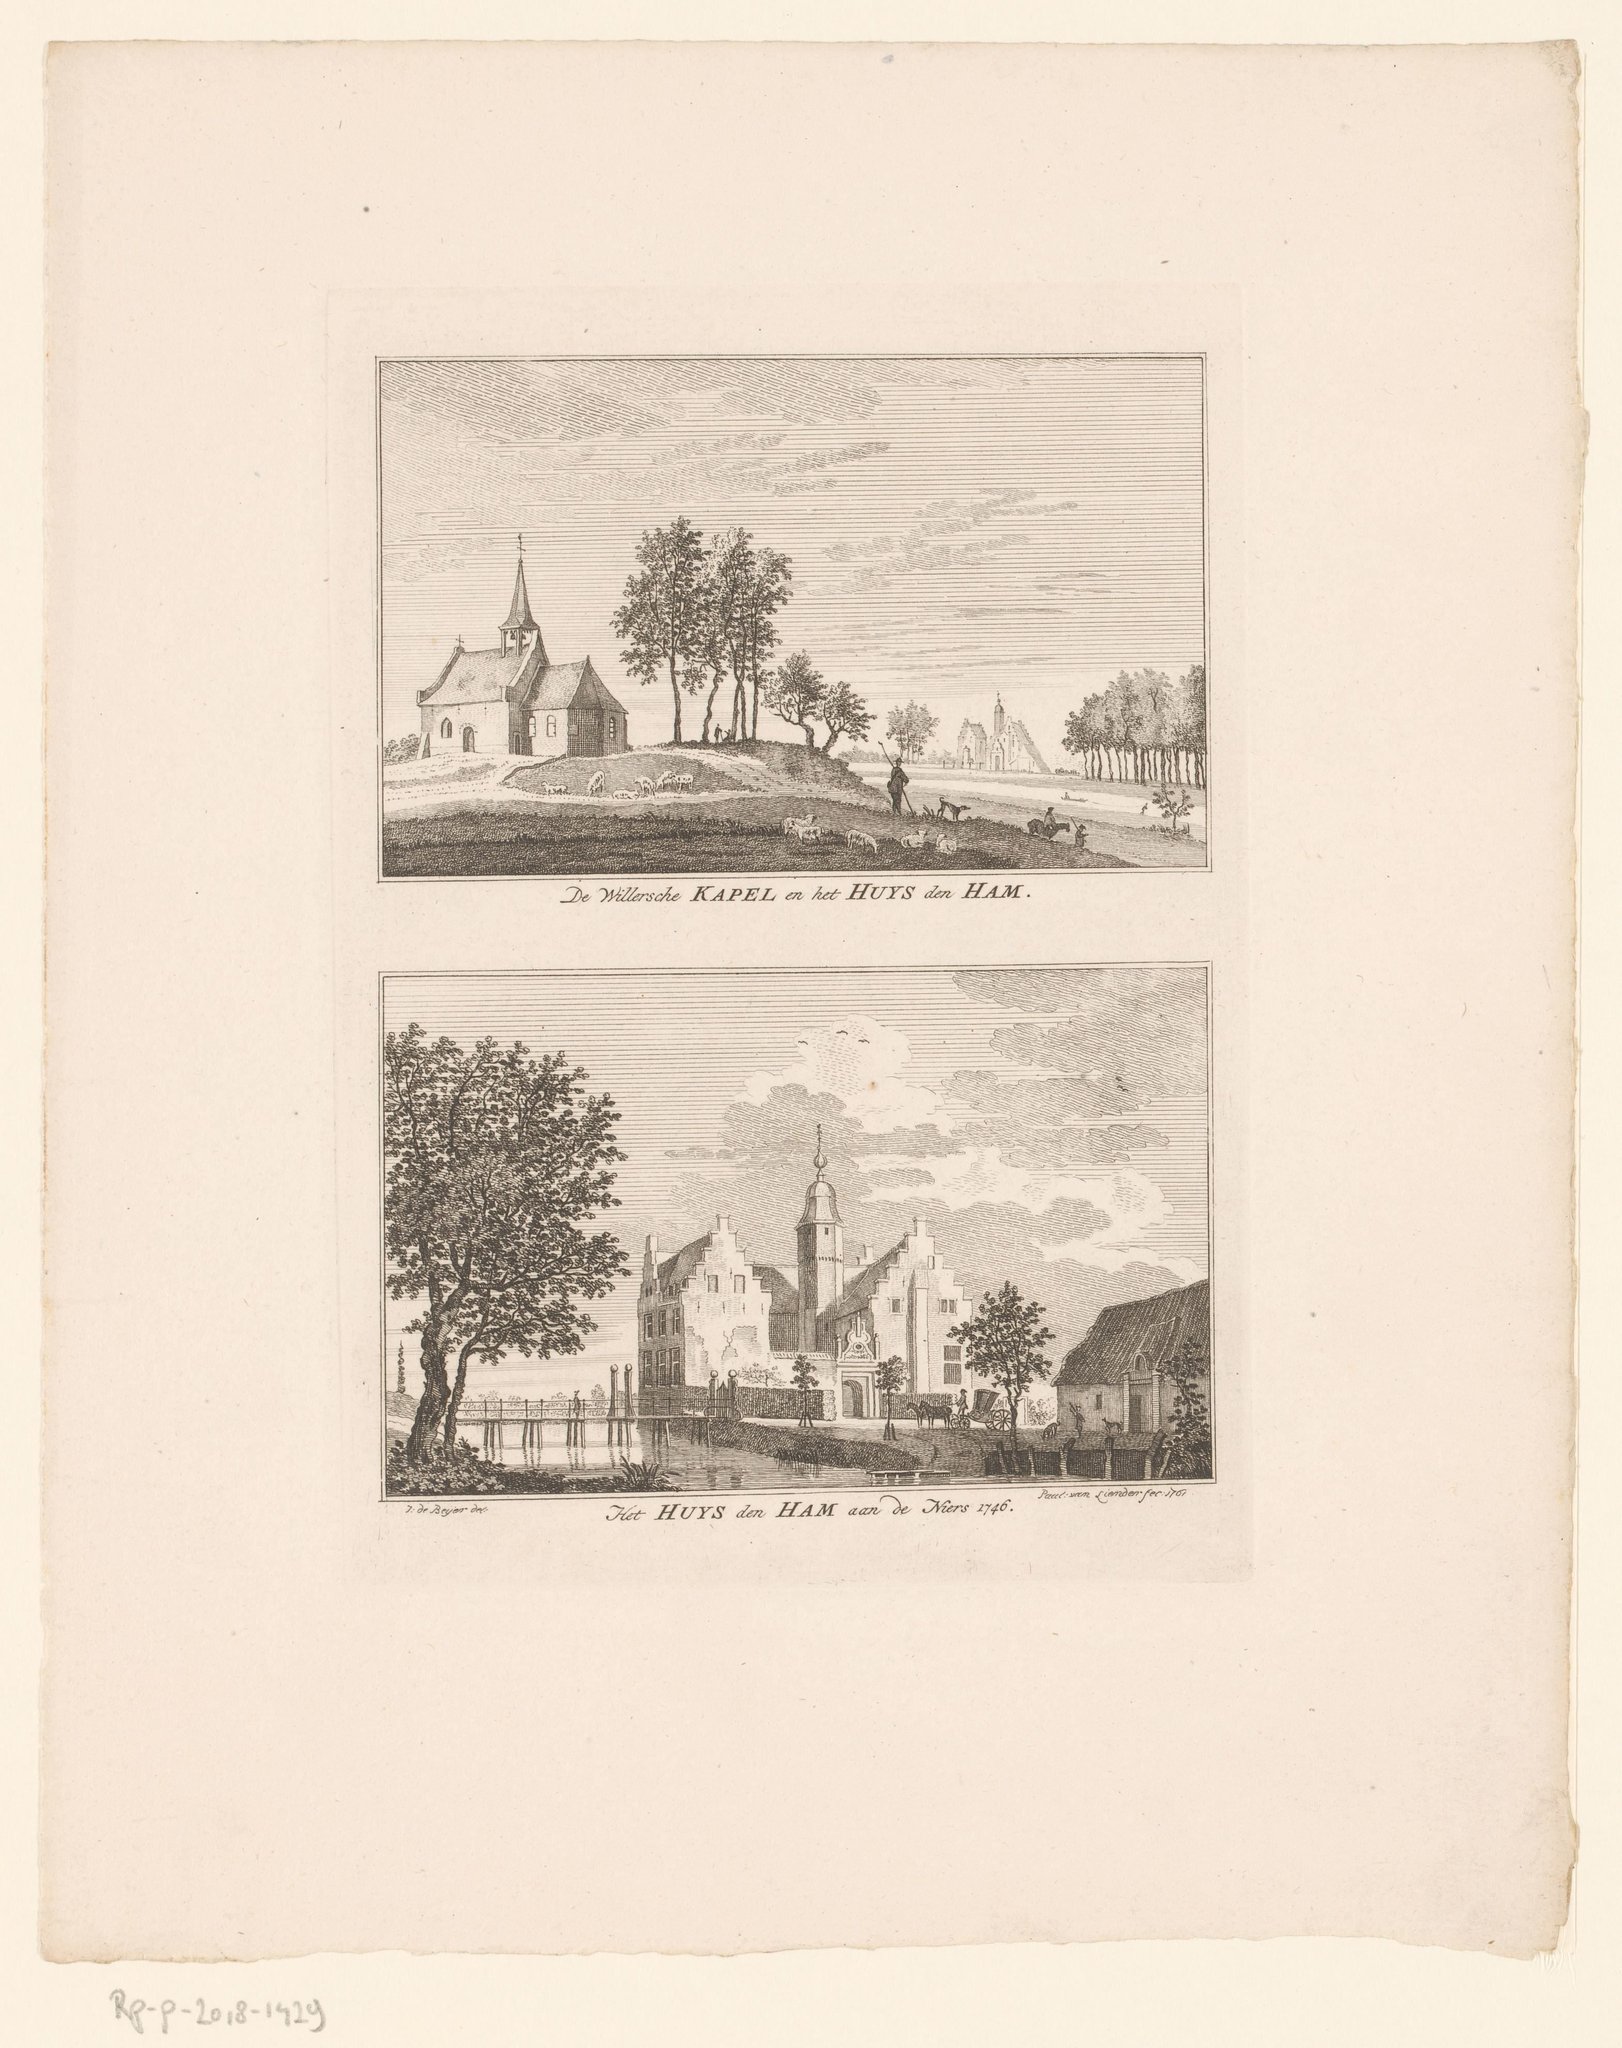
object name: print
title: Willersche kapel en het Huis den Ham, 1746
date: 1761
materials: paper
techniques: etching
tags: city-view, and landscape with man-made constructions, village, church (exterior)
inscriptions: date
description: Twee voorstellingen van één plaat. Gezicht op de Willersche kapel (boven) en het Huis den Ham aan de Niers te Duitsland (onder). De prent maakt deel uit van een 100-delige serie met gezichten op dorpen en steden te Kleef.